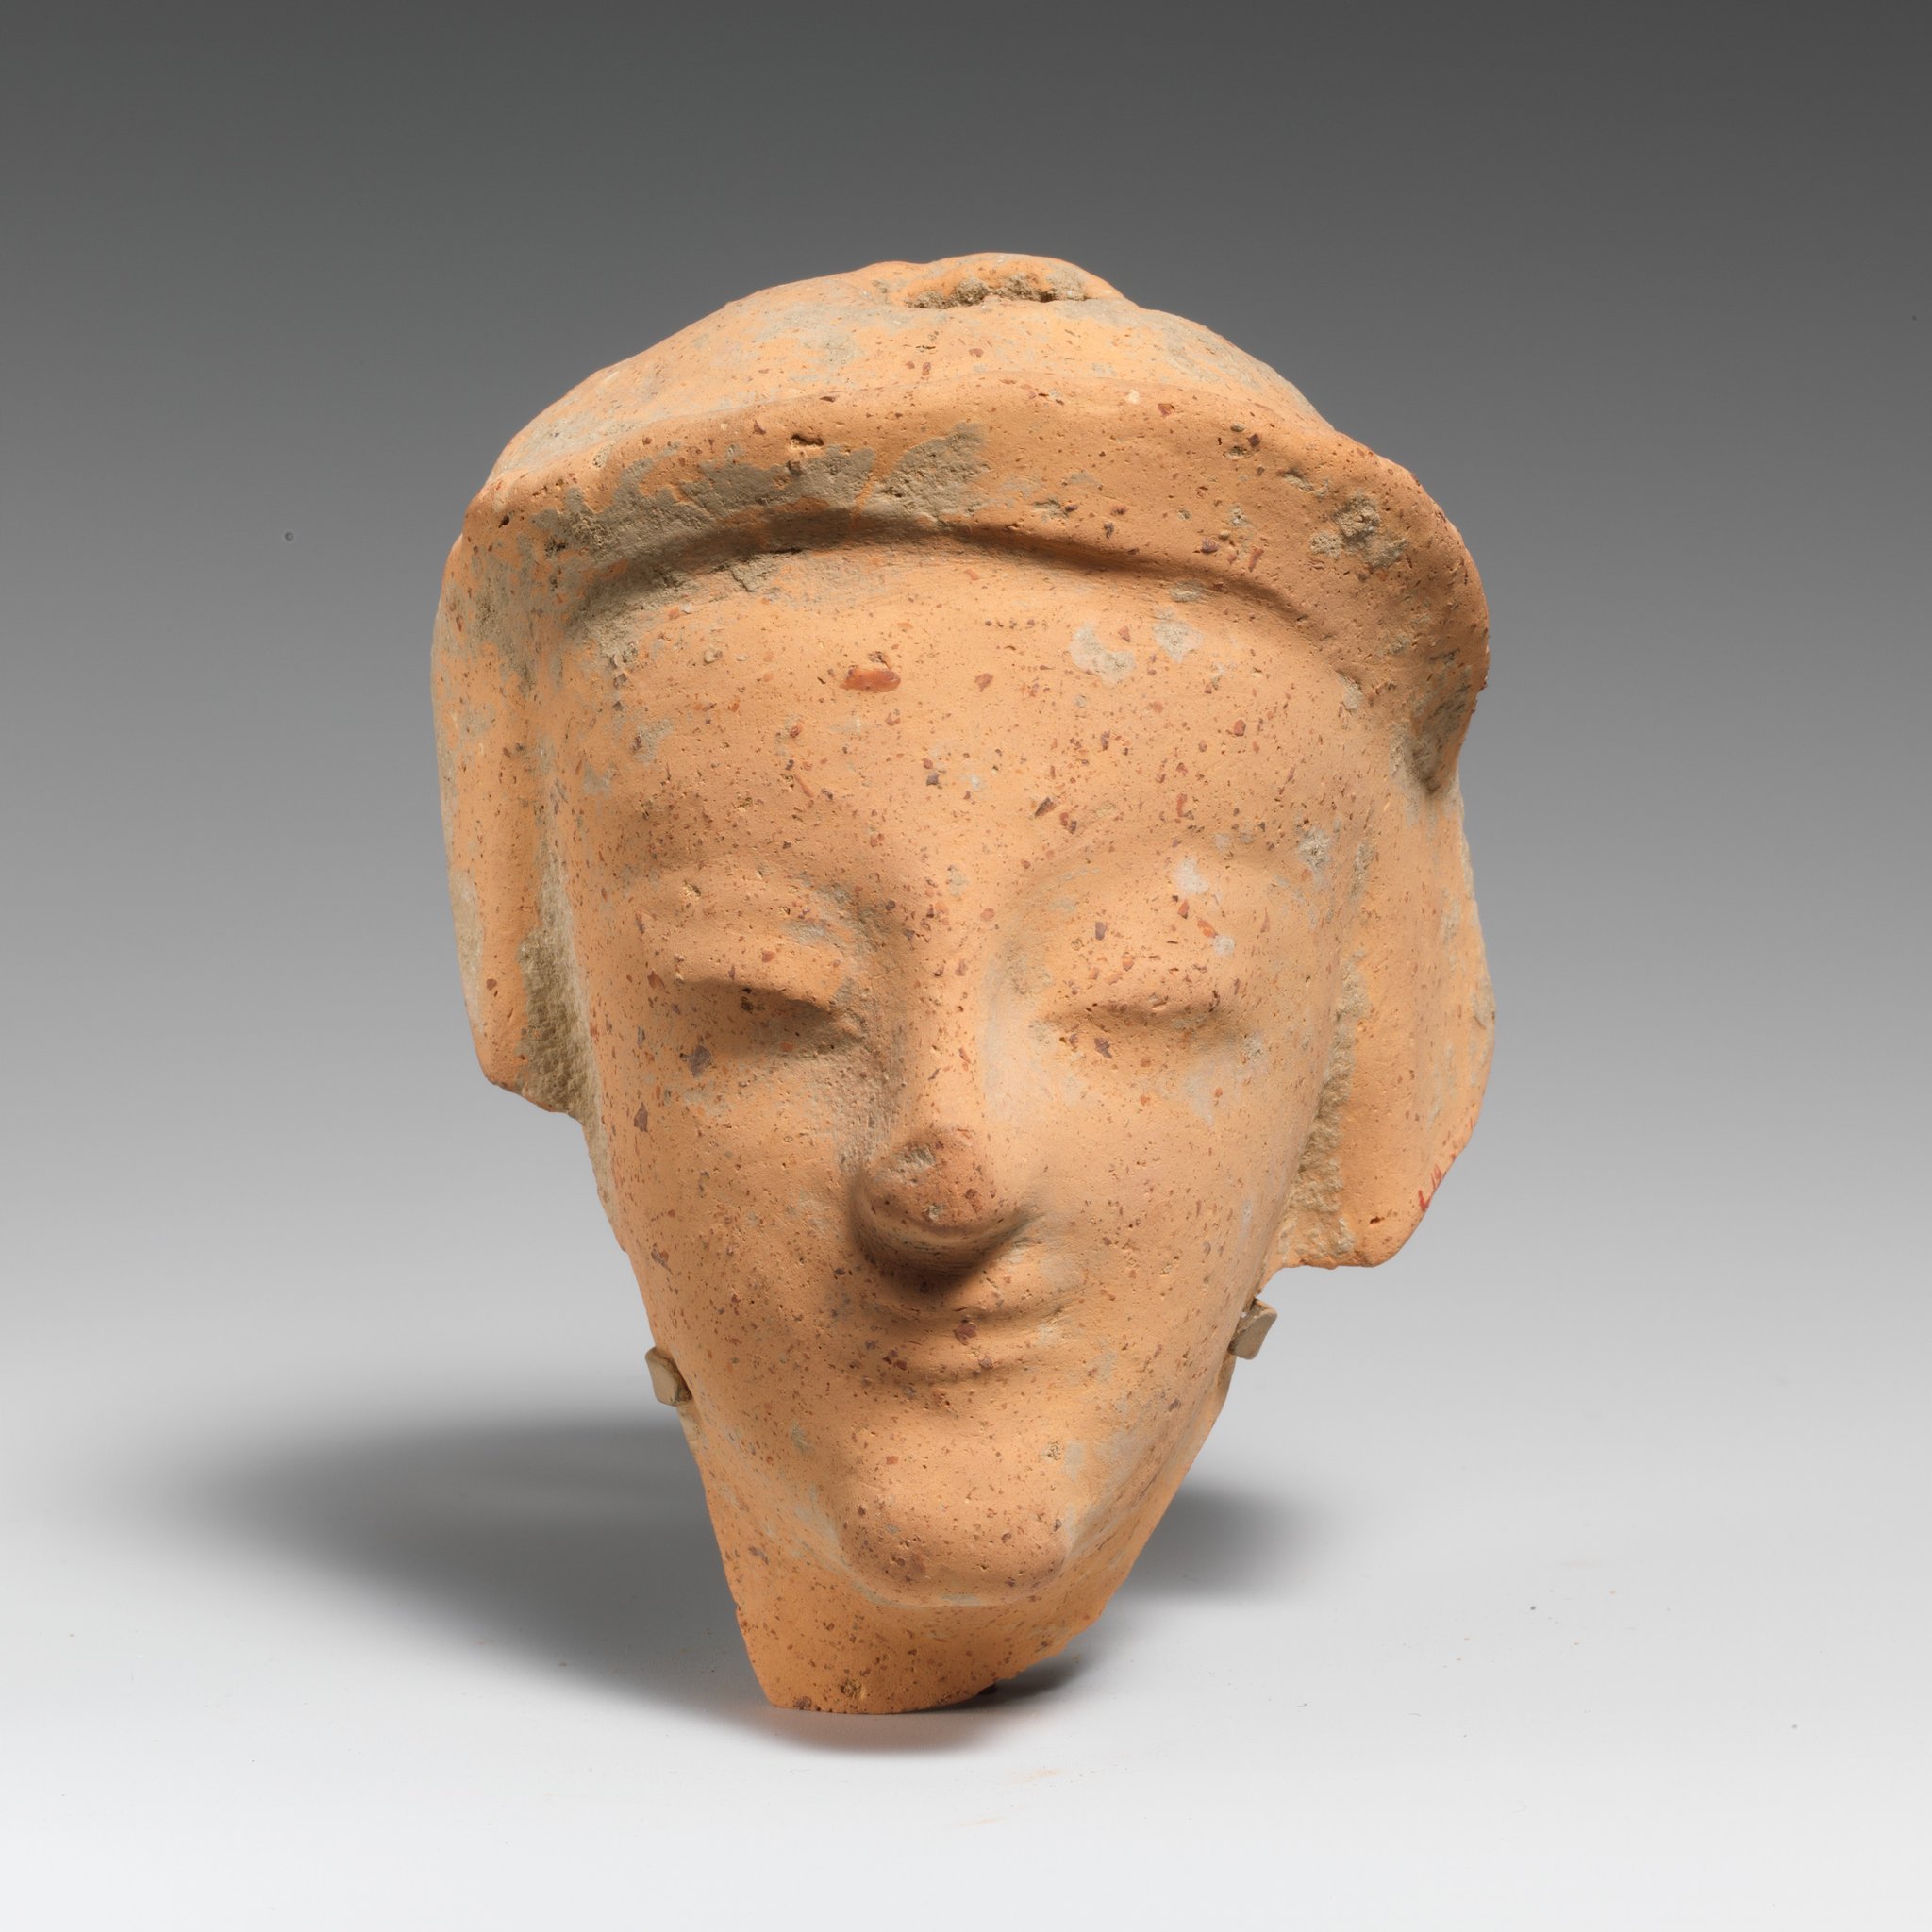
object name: head of a deity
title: Terracotta head of a woman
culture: greek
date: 600-501 BCE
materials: terracotta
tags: heads,women